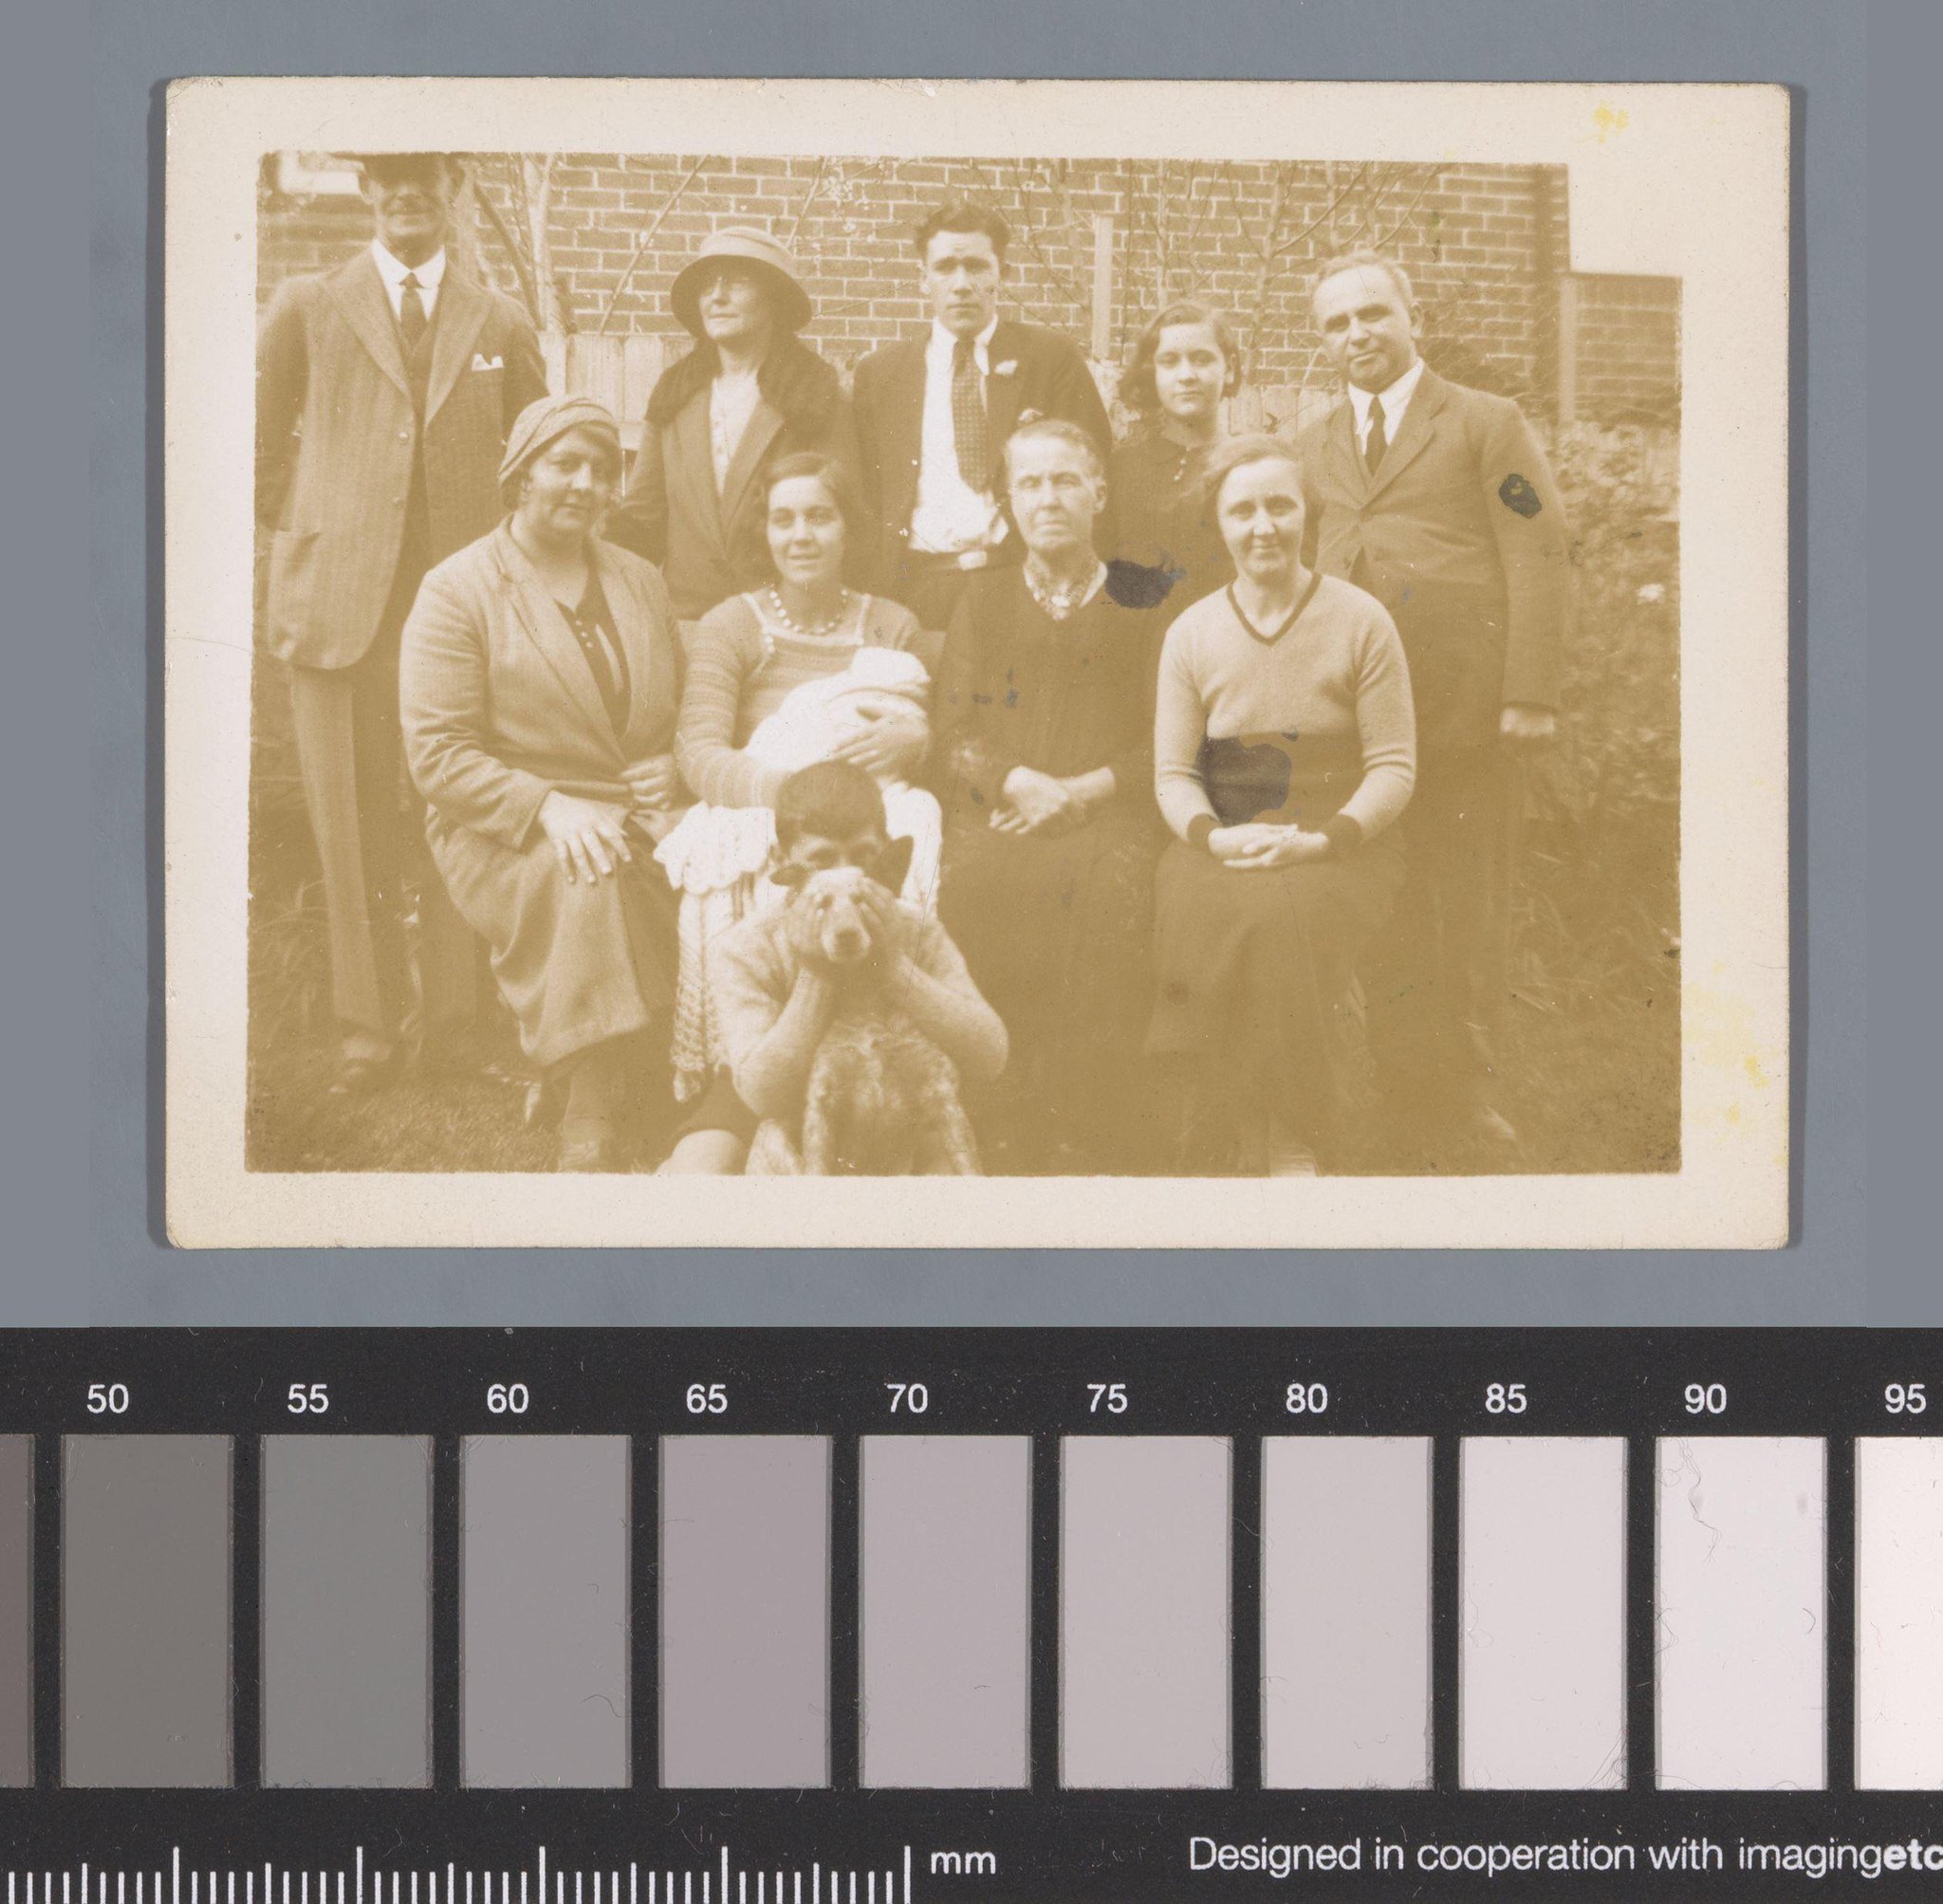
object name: photograph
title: Familieportret in een tuin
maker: Anonymous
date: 1924-1935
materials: photographic support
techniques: gelatin silver print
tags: family, descendance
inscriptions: number: ‘F432’, inscription: ‘Baby a month old he is a little led Barry Morton is his name To Dear Janet’